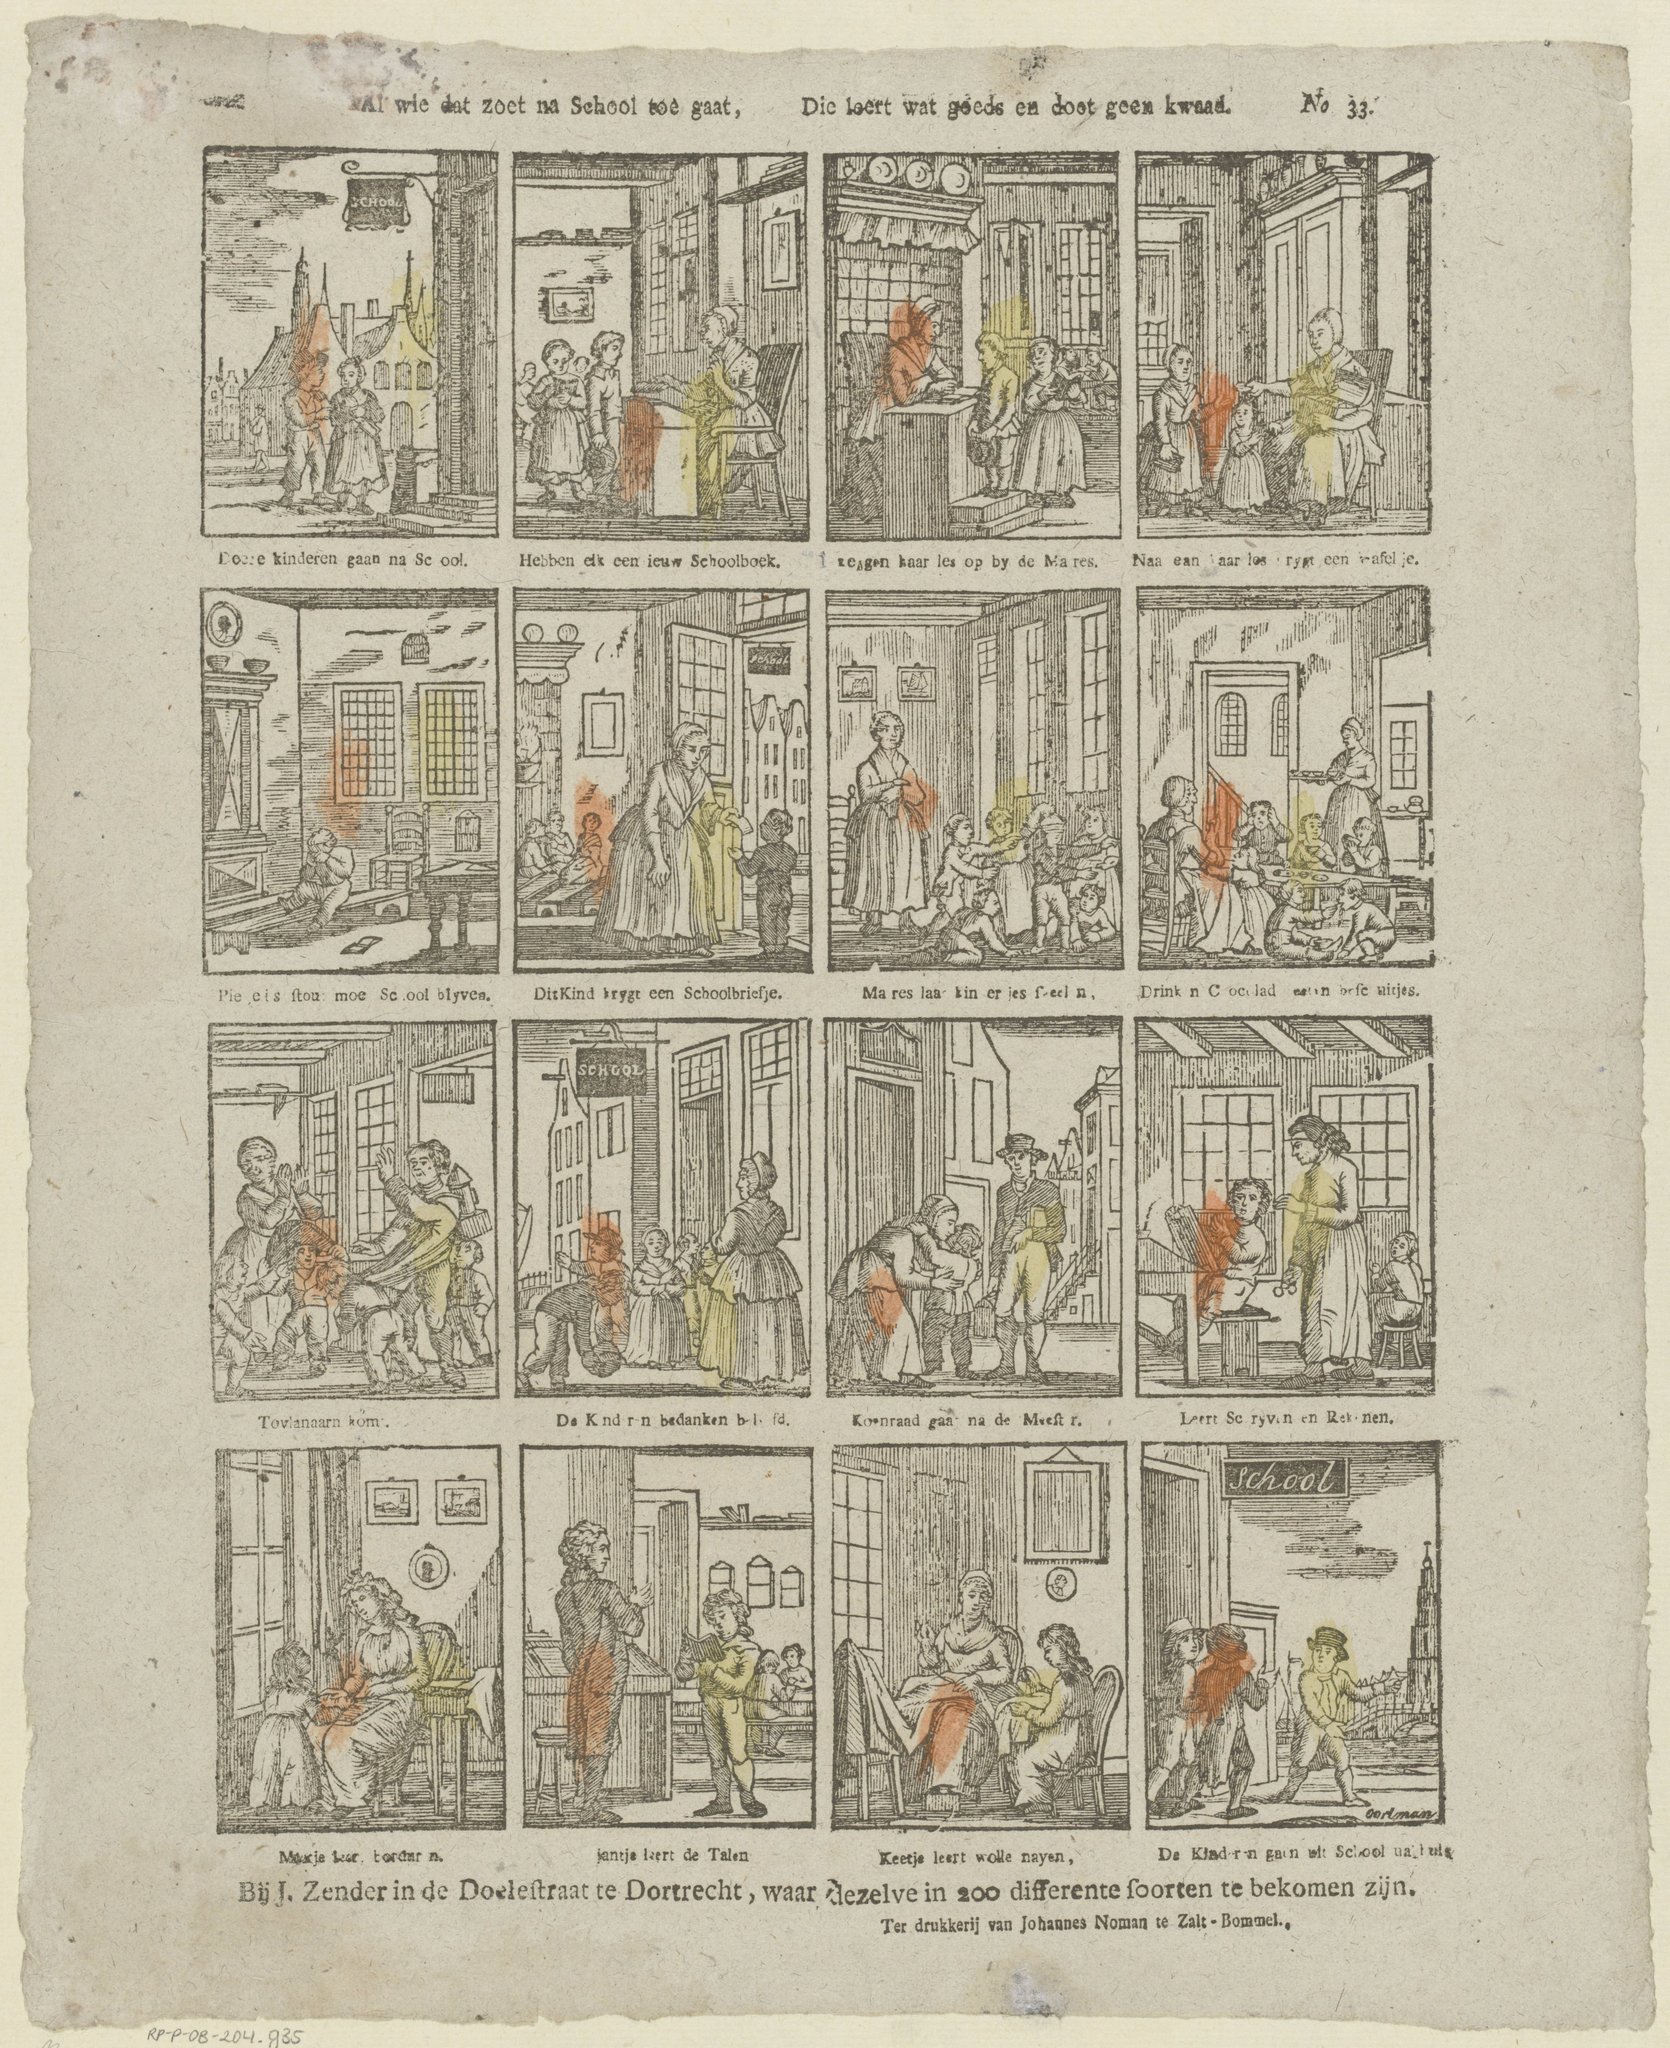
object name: popular print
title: Al wie dat zoet na school toe gaat, / Die leert wat goeds en doet geen kwaad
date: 1806-1830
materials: paper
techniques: colour, letterpress printing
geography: dordrecht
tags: education, science and learning, going to school, child, good behaviour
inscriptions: collector's mark: Lugt 2760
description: Blad met 16 voorstellingen van schoolgaande kinderen. Onder elke afbeelding een onderschrift. Genummerd rechtsboven: No 33.